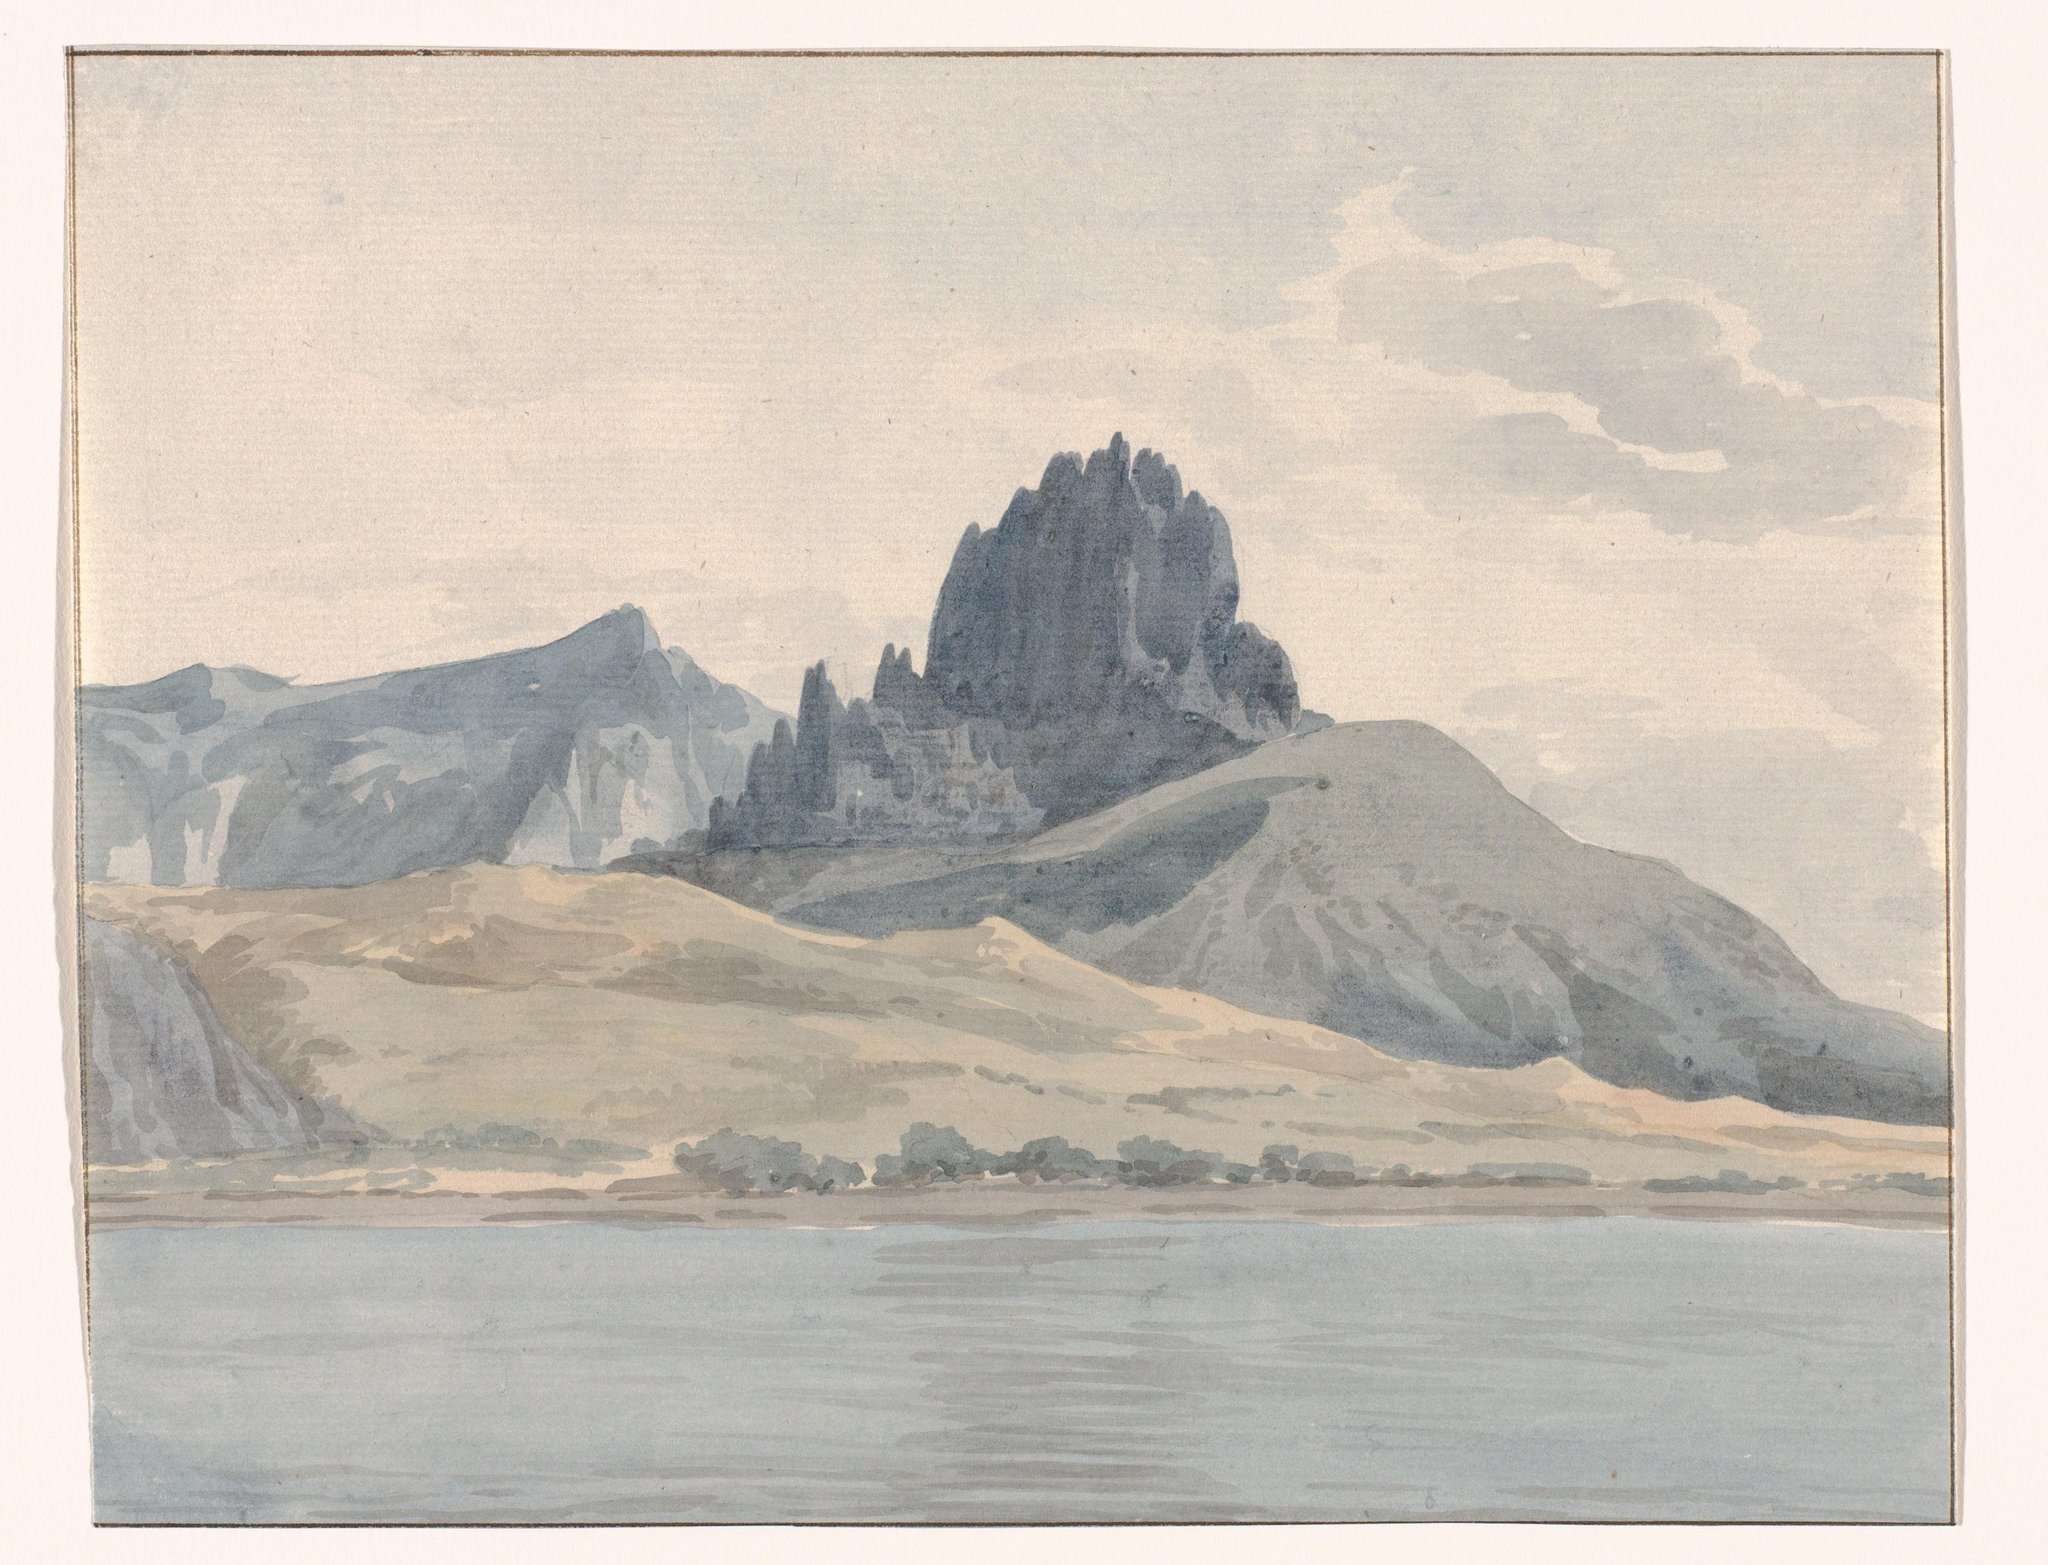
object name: drawing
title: Gezicht op de kust van Pentidatilo aan de overzijde van kaap Spartivento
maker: louis ducros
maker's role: draughtsman, print maker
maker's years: 1748-1810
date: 1778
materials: chalk, paper, watercolor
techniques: brush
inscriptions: number: ‘No 125 Vue de la côte de Pentidatilo au delà du Cap de Spartivento’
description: Tekening uit het album 'Voyage en Italie, en Sicile et à Malte', 1778.